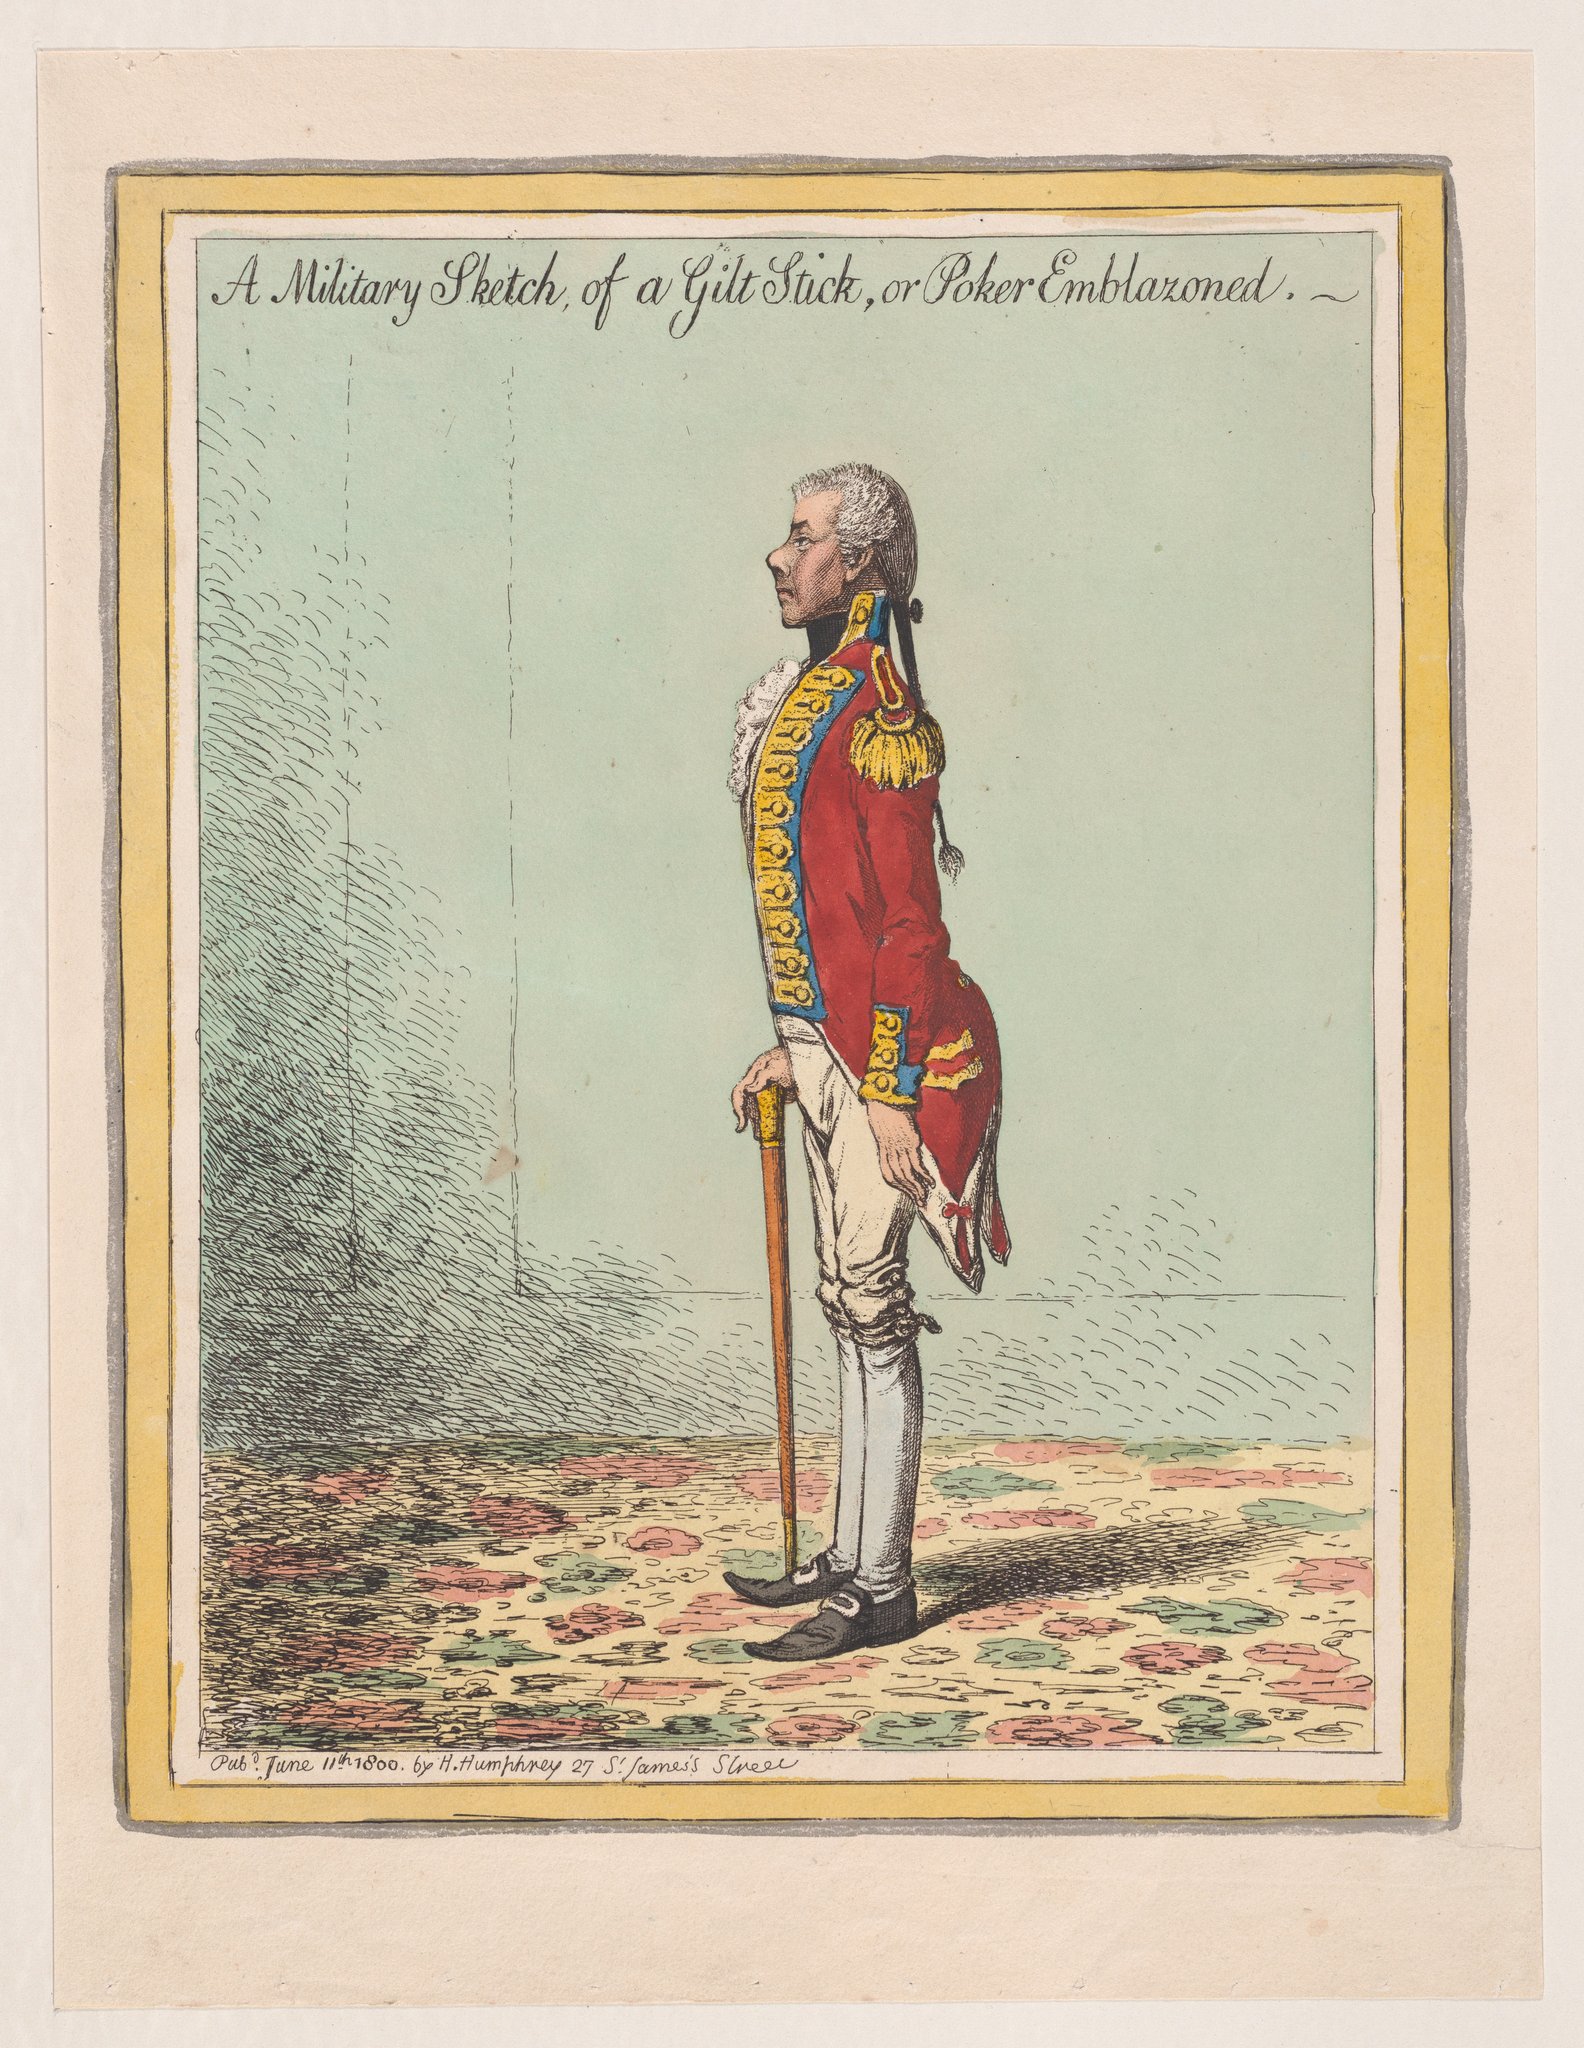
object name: print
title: A Military Sketch, of a Gilt Stick, or Poker Emblazoned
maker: james gillray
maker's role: artist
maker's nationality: british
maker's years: 1756-1815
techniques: etching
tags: men,caricature